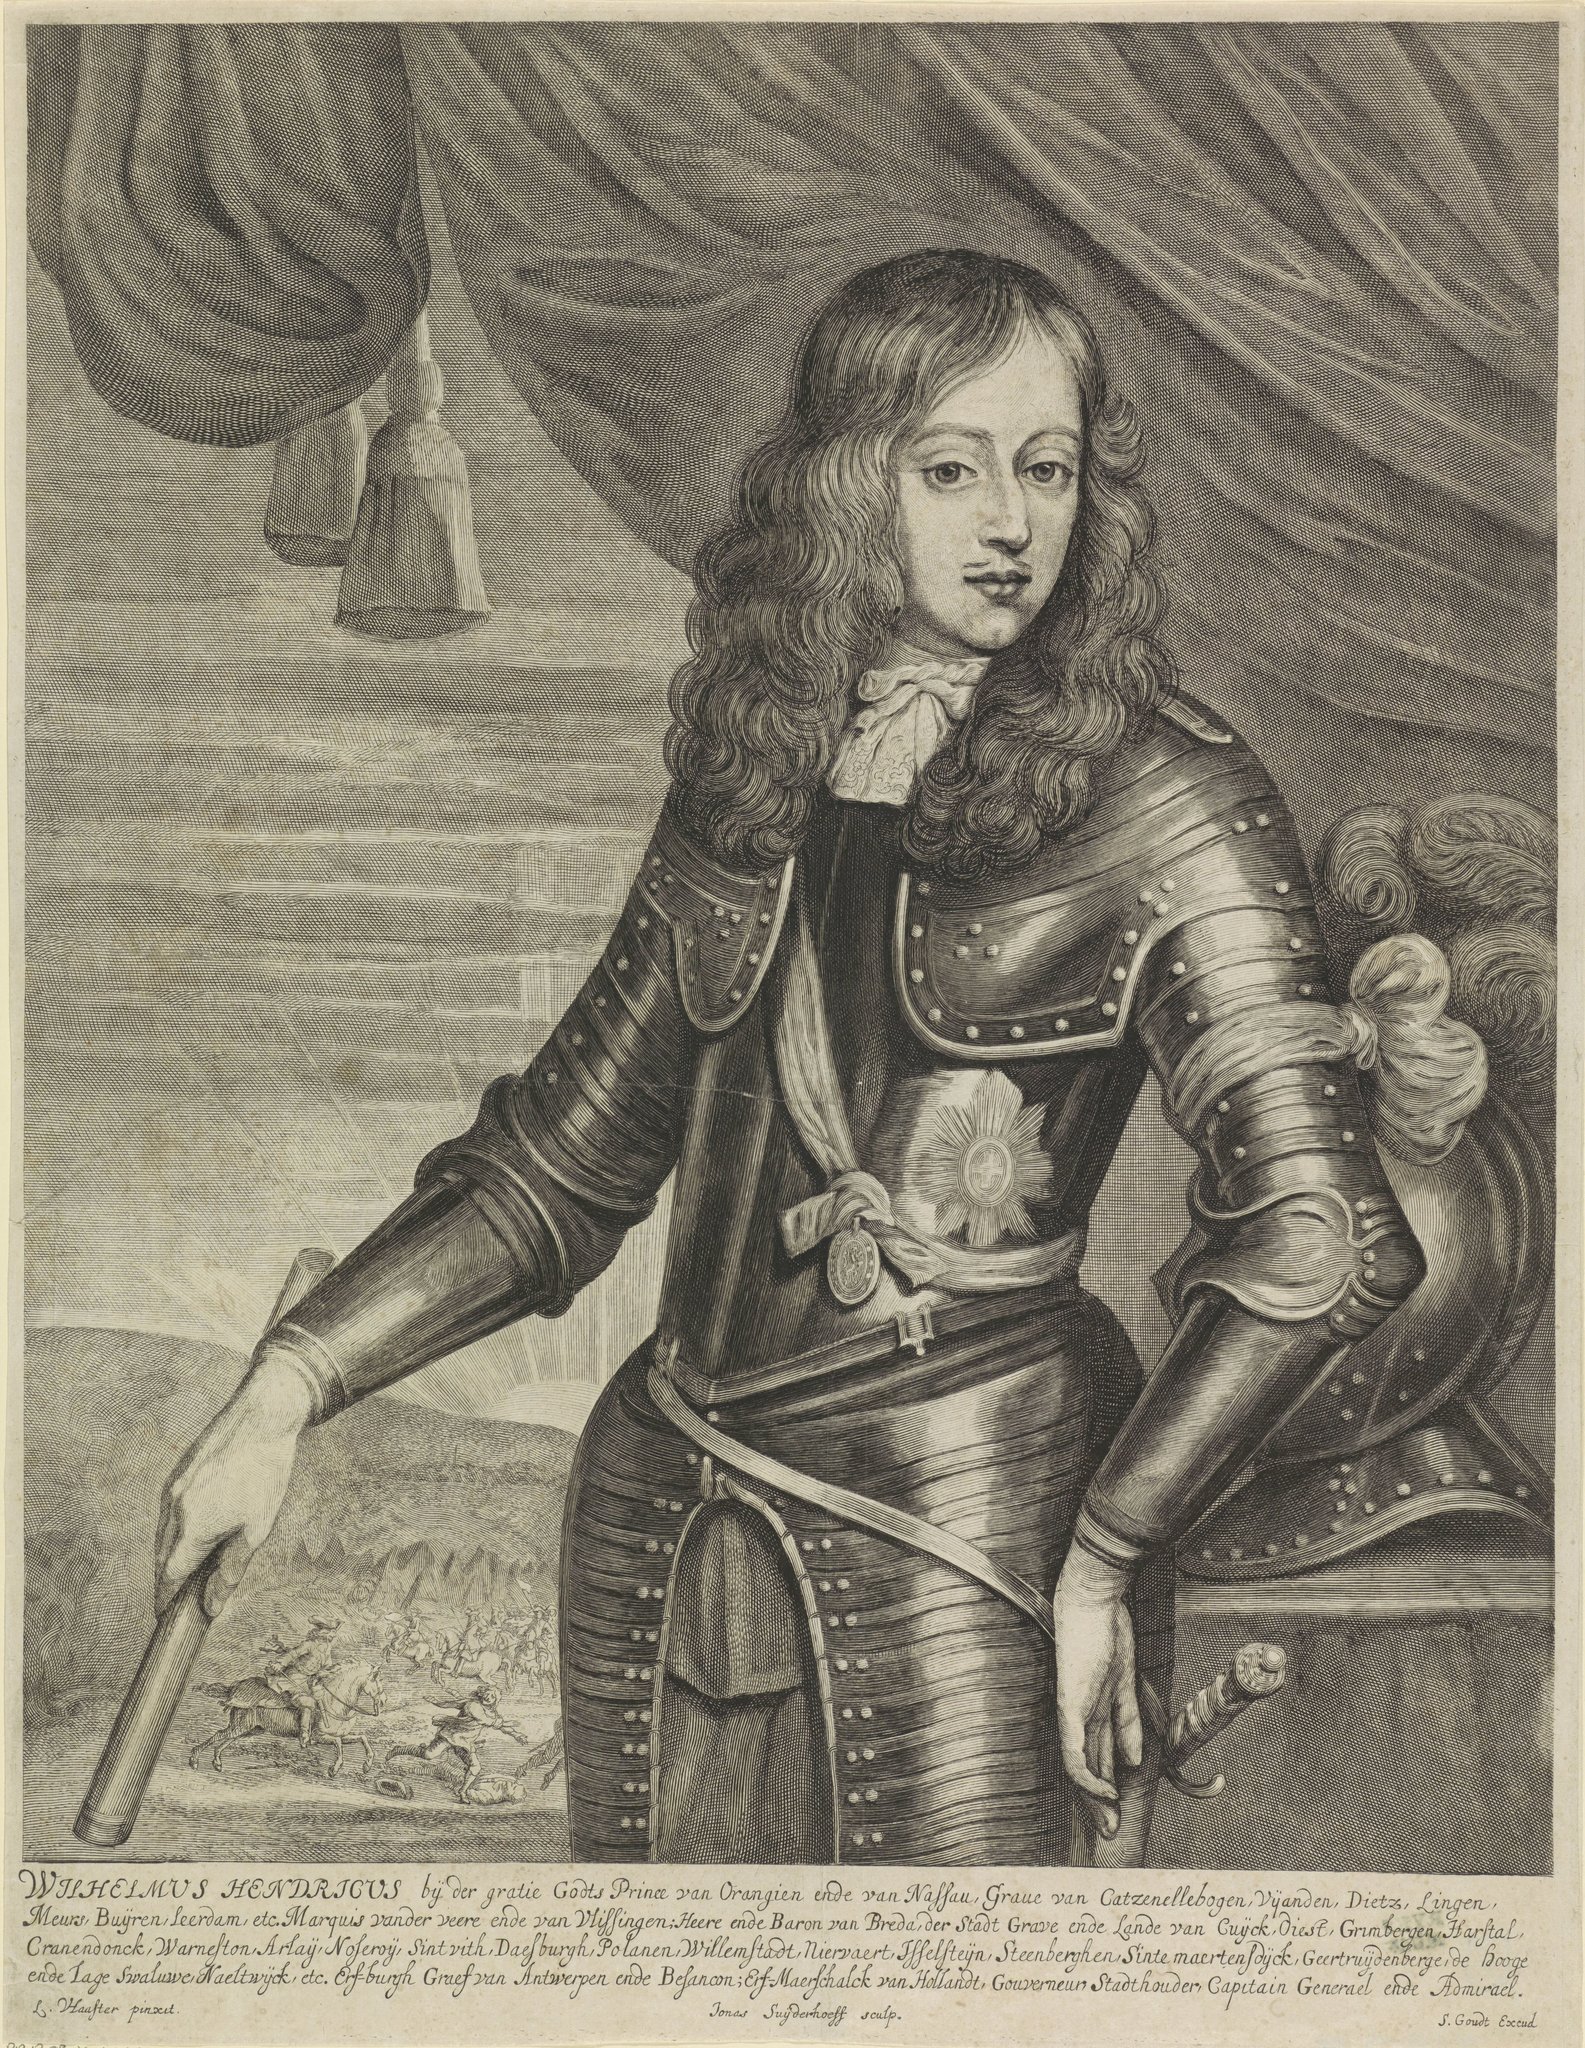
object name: print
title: Portret van Willem III, prins van Oranje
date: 1623-1686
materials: paper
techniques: engraving, etching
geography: haarlem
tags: the hague, william iii (prince of orange and king of england, scotland, and ireland)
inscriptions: collector's mark: Lugt 2165, collector's mark: Lugt 963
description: De hier vermelde titel verwijst naar de hoogst verkregen titel van de geportretteerde, niet per se naar de titel die de geportretteerde op deze voorstelling draagt.